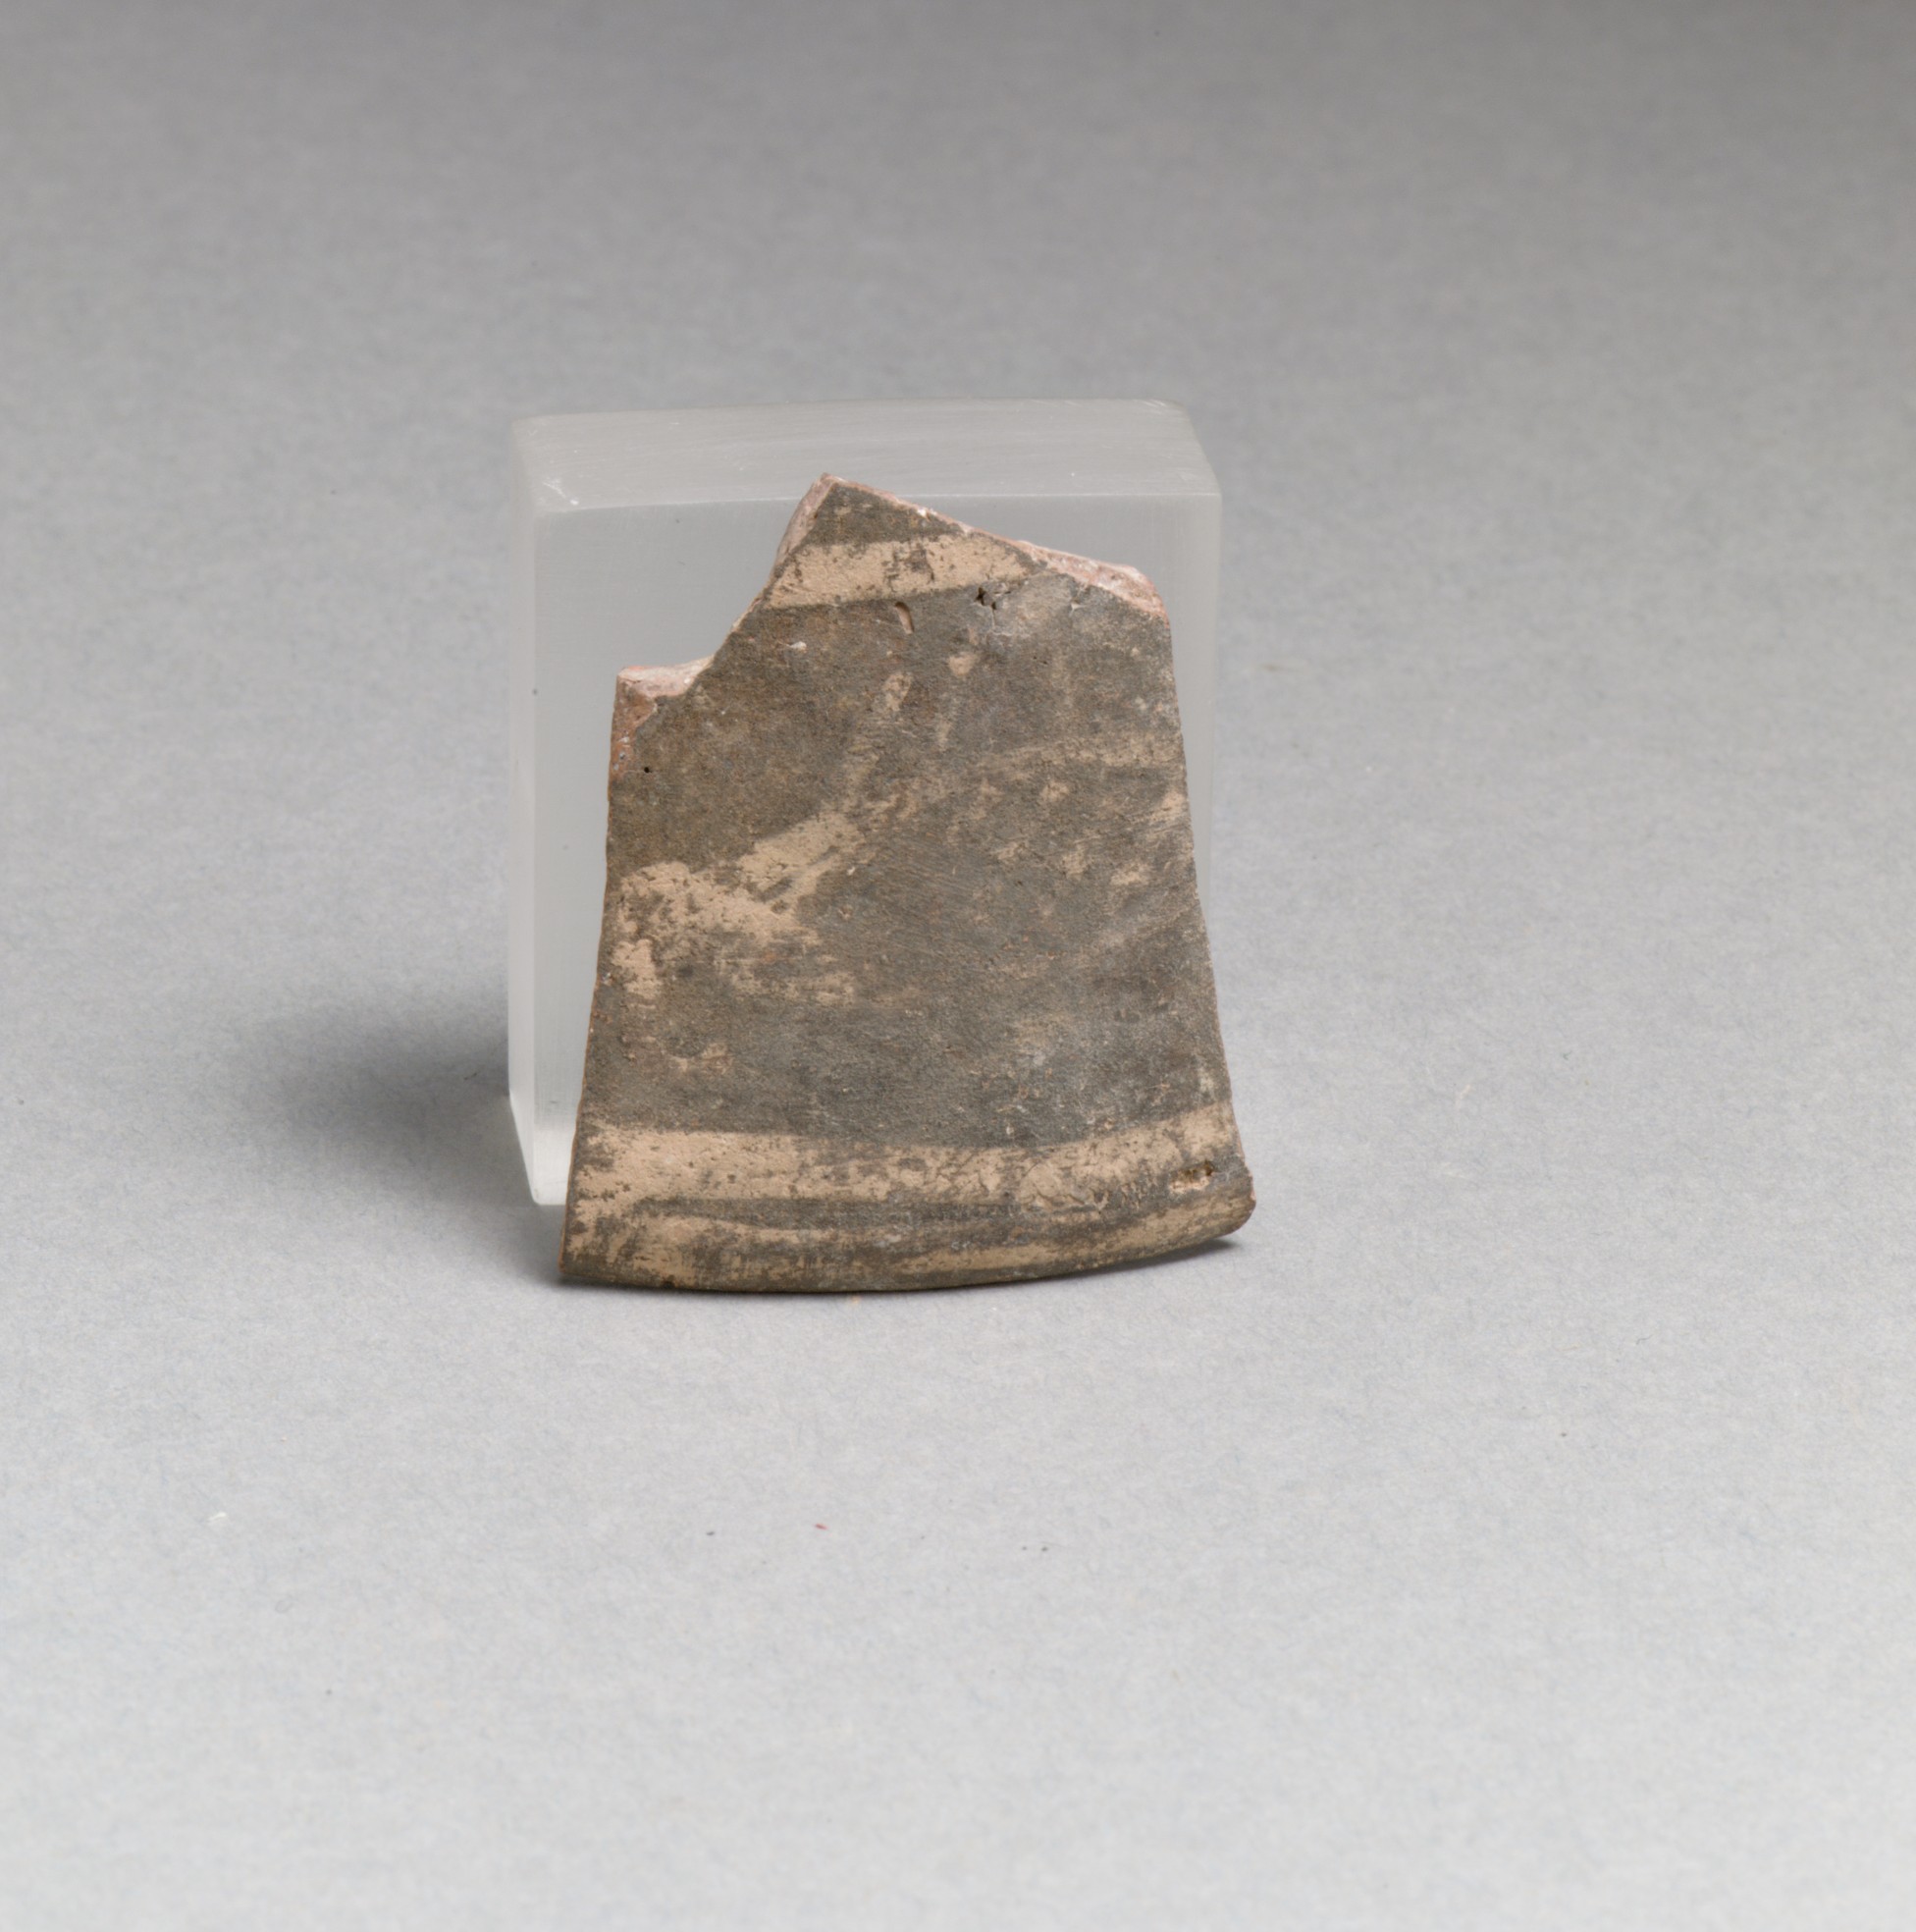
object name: vase fragment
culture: minoan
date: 2600-2000 BCE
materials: terracotta